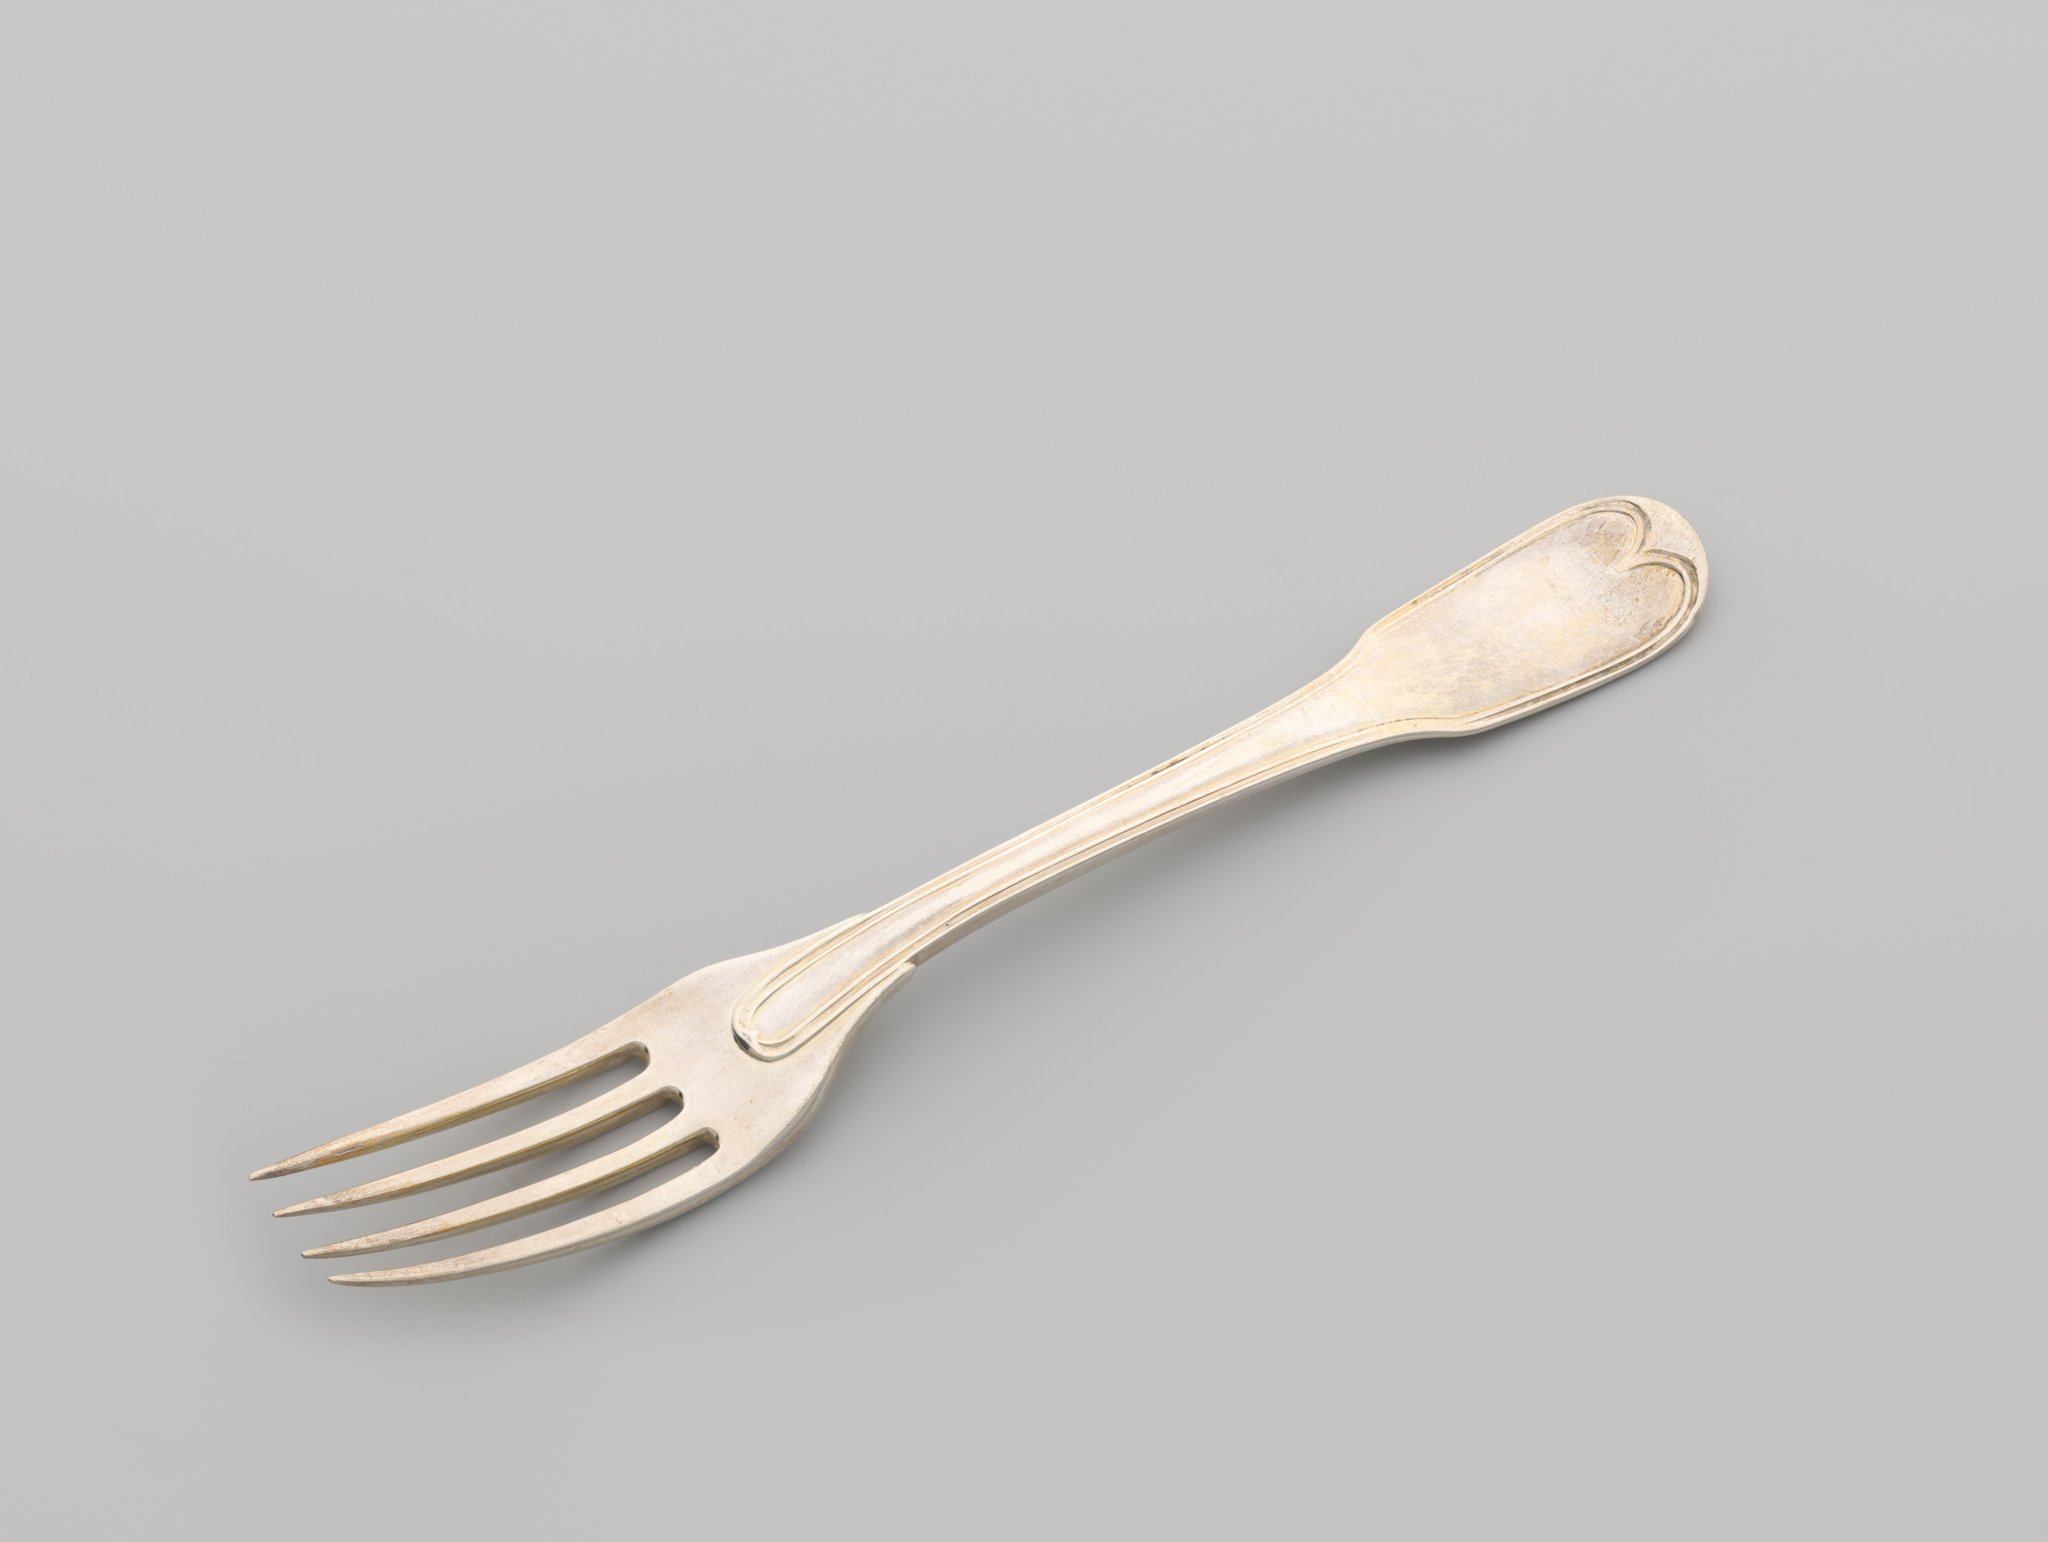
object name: dessert fork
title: Dessertvork met het helmteken Clifford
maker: roelof helweg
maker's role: silversmith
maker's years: 1758-1843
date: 1806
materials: silver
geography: amsterdam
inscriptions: maker's mark: ‘RH in ovaal’, town mark: ‘Amsterdam’, date letter: ‘X (=1806)’, alloy mark: ‘Hollandse leeuw’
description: De viertandige vork is aan zowel boven- als onderzijde door middel van enkel lof verbonden met de platte, gebogen steel, die zich verbreedt naar het spatelvormige uiteinde. Boven- en onderzijde van de steel worden omgeven door een dubbele filetrand, die bij het uiteinde ingezwenkt is. Op de onderzijde van de spatel is het helmteken Clifford gegraveerd.